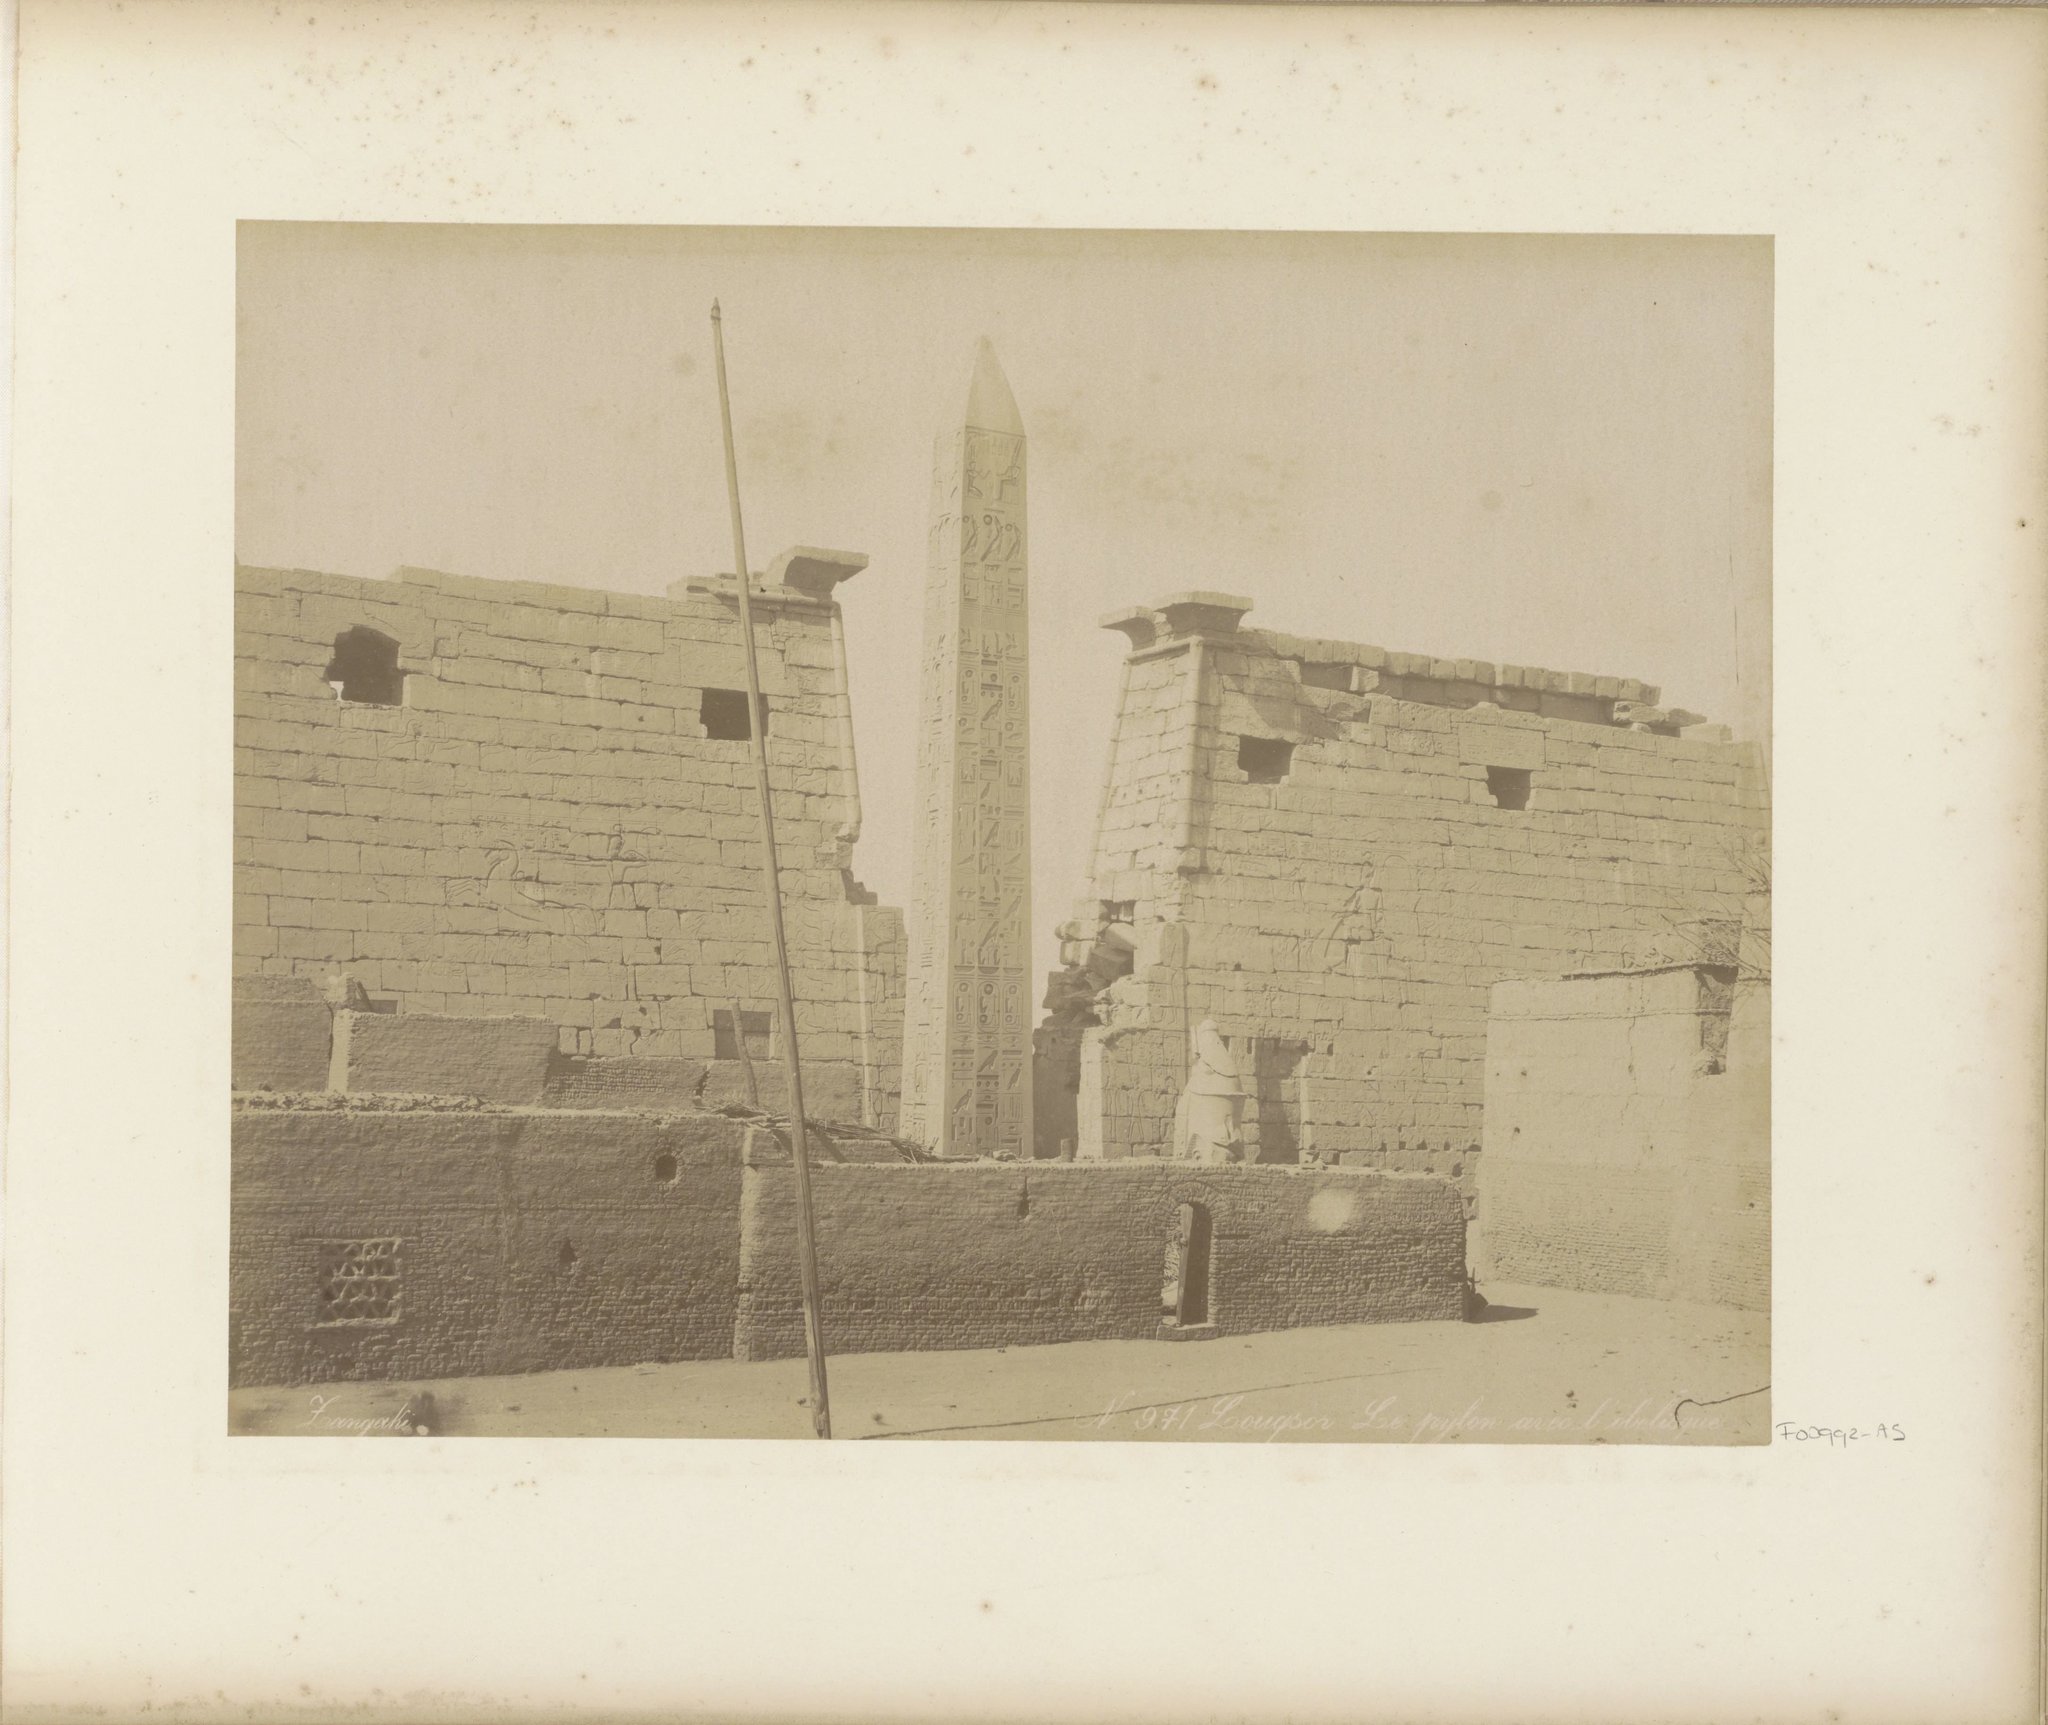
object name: photograph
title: Pyloon met obelisk in Luxor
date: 1870-1890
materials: cardboard, paper, photographic support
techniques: albumen print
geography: luxor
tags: obelisk, needle, gate, entrance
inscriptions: negative number: ‘971’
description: Onderdeel van Reisalbum met 80 foto's van Egypte.